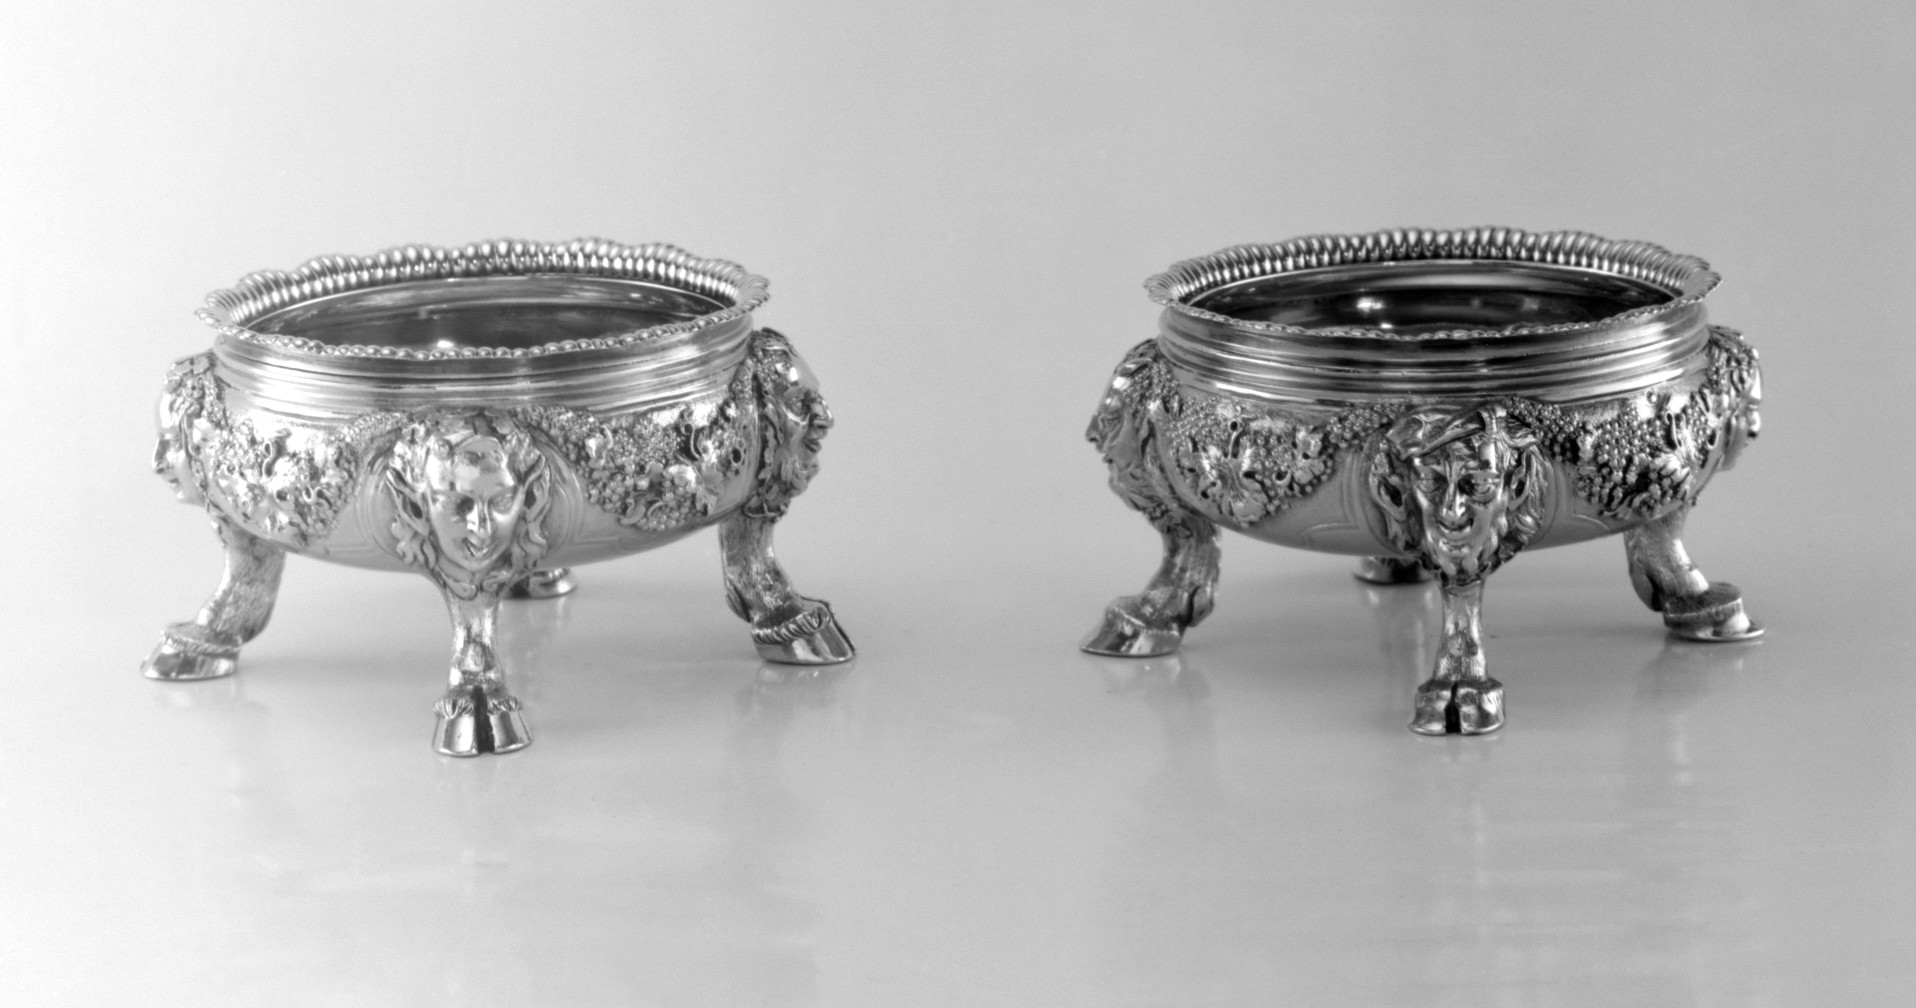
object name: saltcellar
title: Set of four saltcellars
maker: paul de lamerie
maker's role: maker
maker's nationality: british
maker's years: 1688-1751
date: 1737-1738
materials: silver gilt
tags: faces